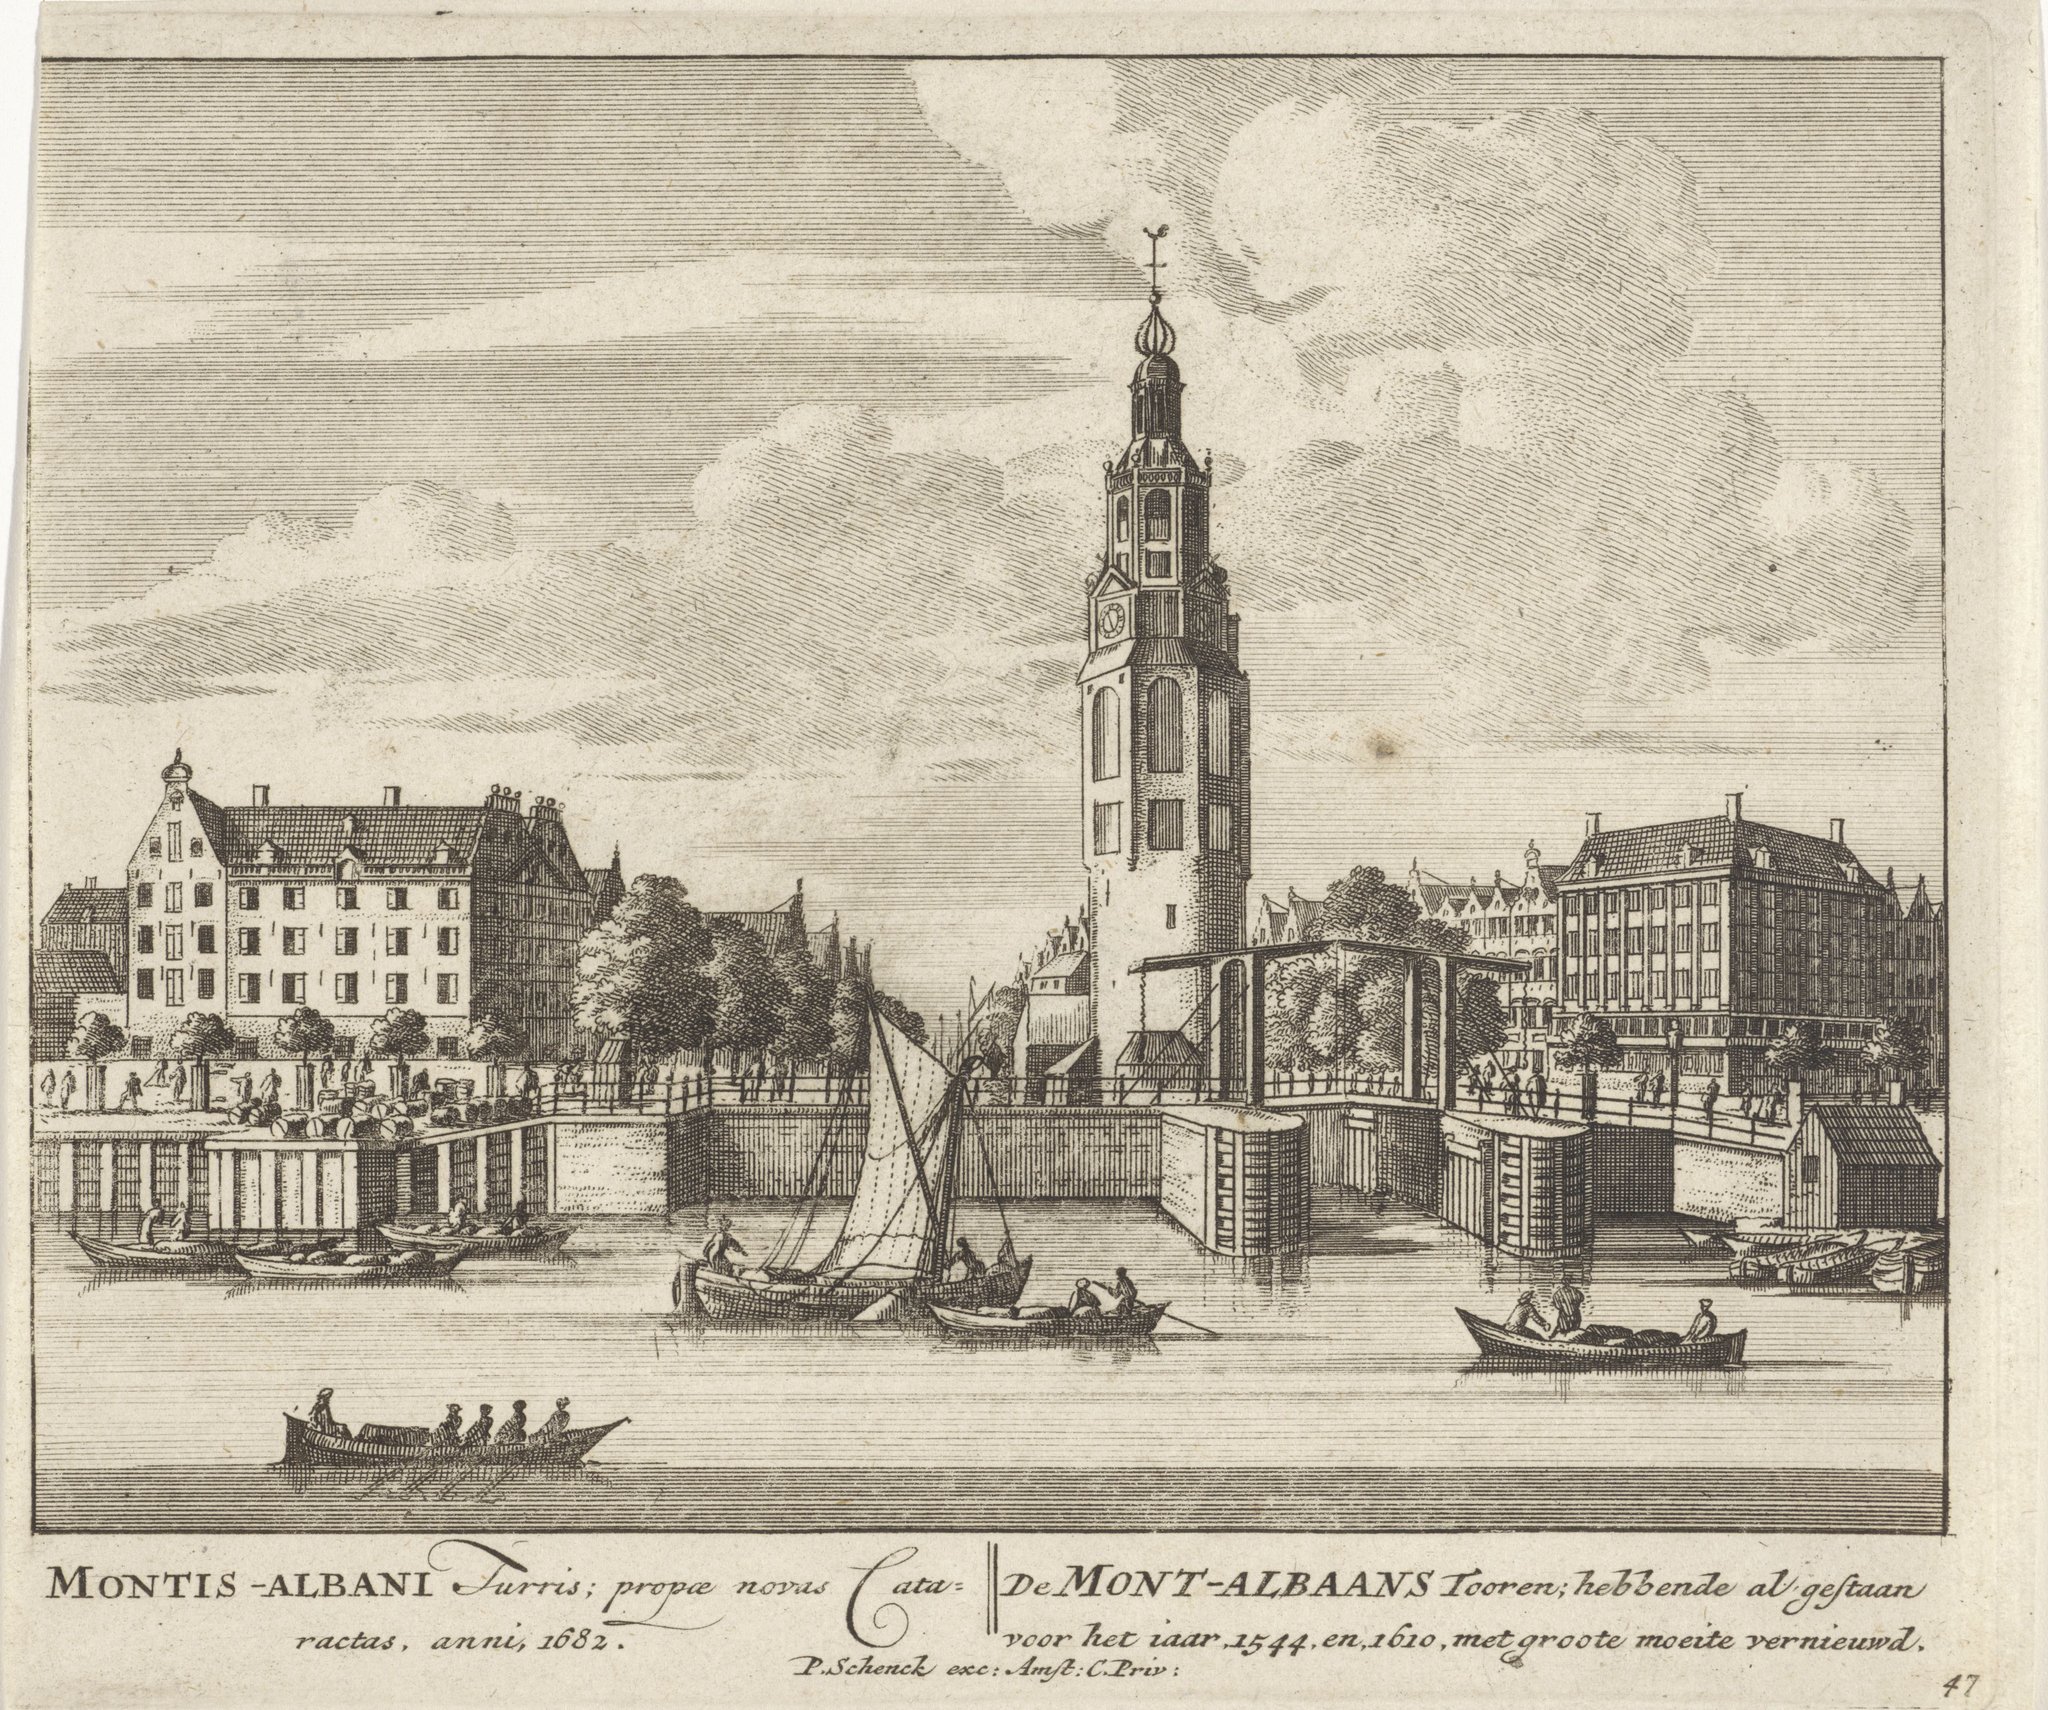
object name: print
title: Gezicht op de Oudeschans en de Montelbaanstoren te Amsterdam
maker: Anonymous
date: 1710-1711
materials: paper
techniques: engraving, etching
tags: tower, clock tower ~ monumental adornment, lift-lock, canal lock, street (+ city(-scape) with figures, staffage)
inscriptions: collector's mark: Lugt 2228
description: Huidige staat van prent ook gebruikt in: 100 Afbeeldinge der voornaamste gebouwen van Amsterdam. Amsterdam, Pieter Schenk (I), s.a. [1710-1711]. En in: 100 Afbeeldinge der voornaamste gebouwen van Amsterdam. Amsterdam, Barent Greve, s.a. [1757-1766].* *In de tweede uitgave, uitgegeven door Barent Greve, is alleen de titelprent aangepast. De overige prenten zijn onveranderd gebleven.